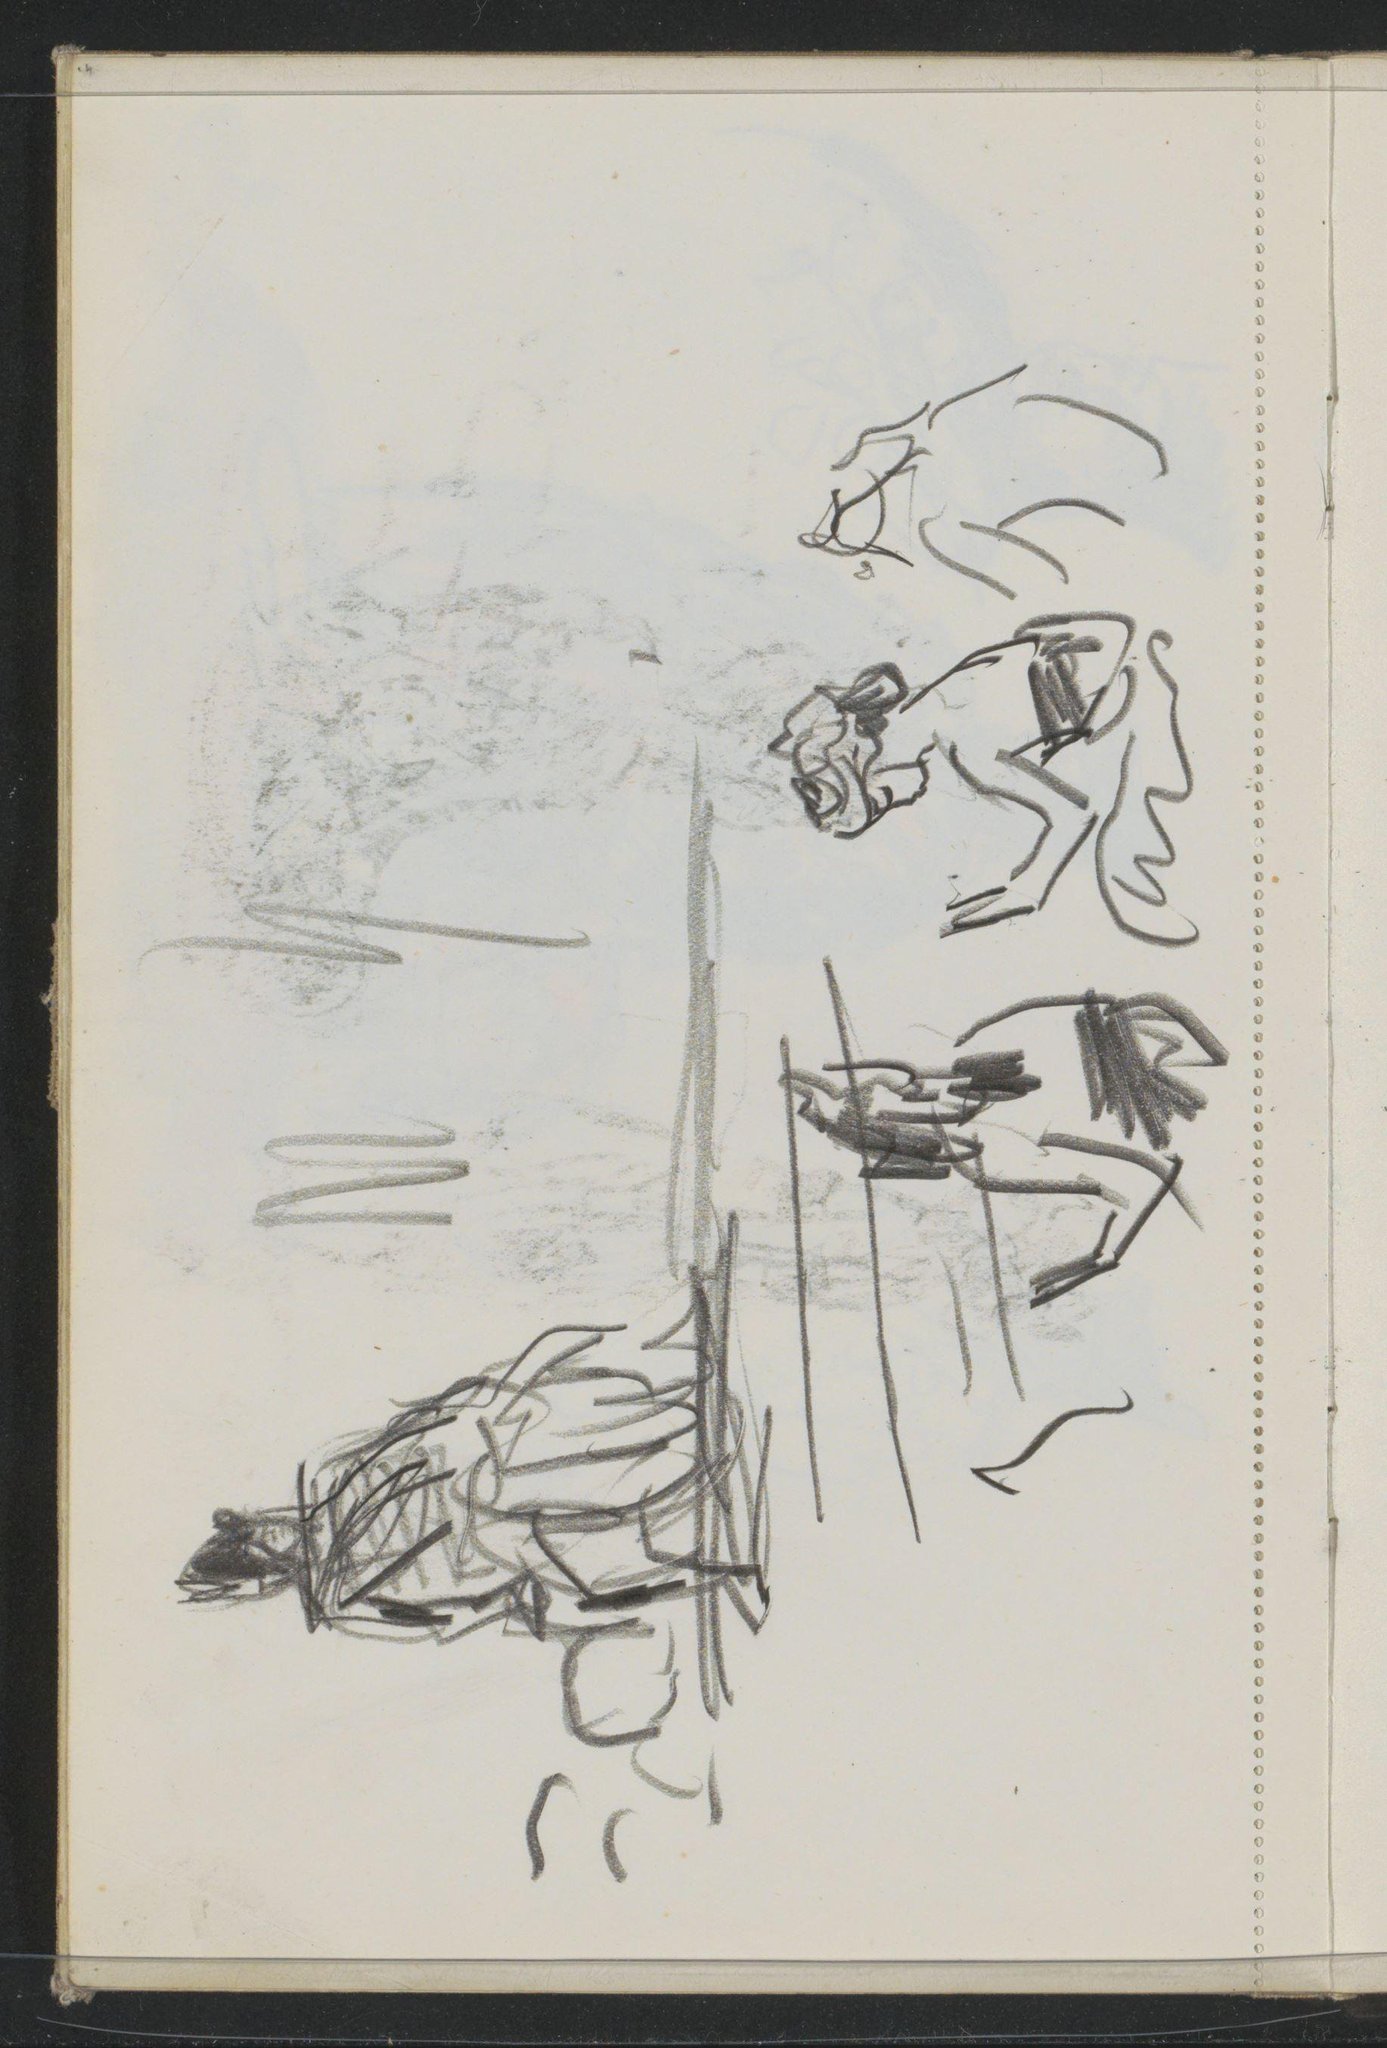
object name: sketchbook leaf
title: Serimpies bij de Sultan aan het Hof van Djokja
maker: marius bauer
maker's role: draughtsman, print maker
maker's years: 1867-1932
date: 1925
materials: paper, pencil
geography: indonesia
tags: group of women (folk dancing), (military) uniforms, dignitary at court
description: Pagina 14 uit een schetsboek met 74 bladen.